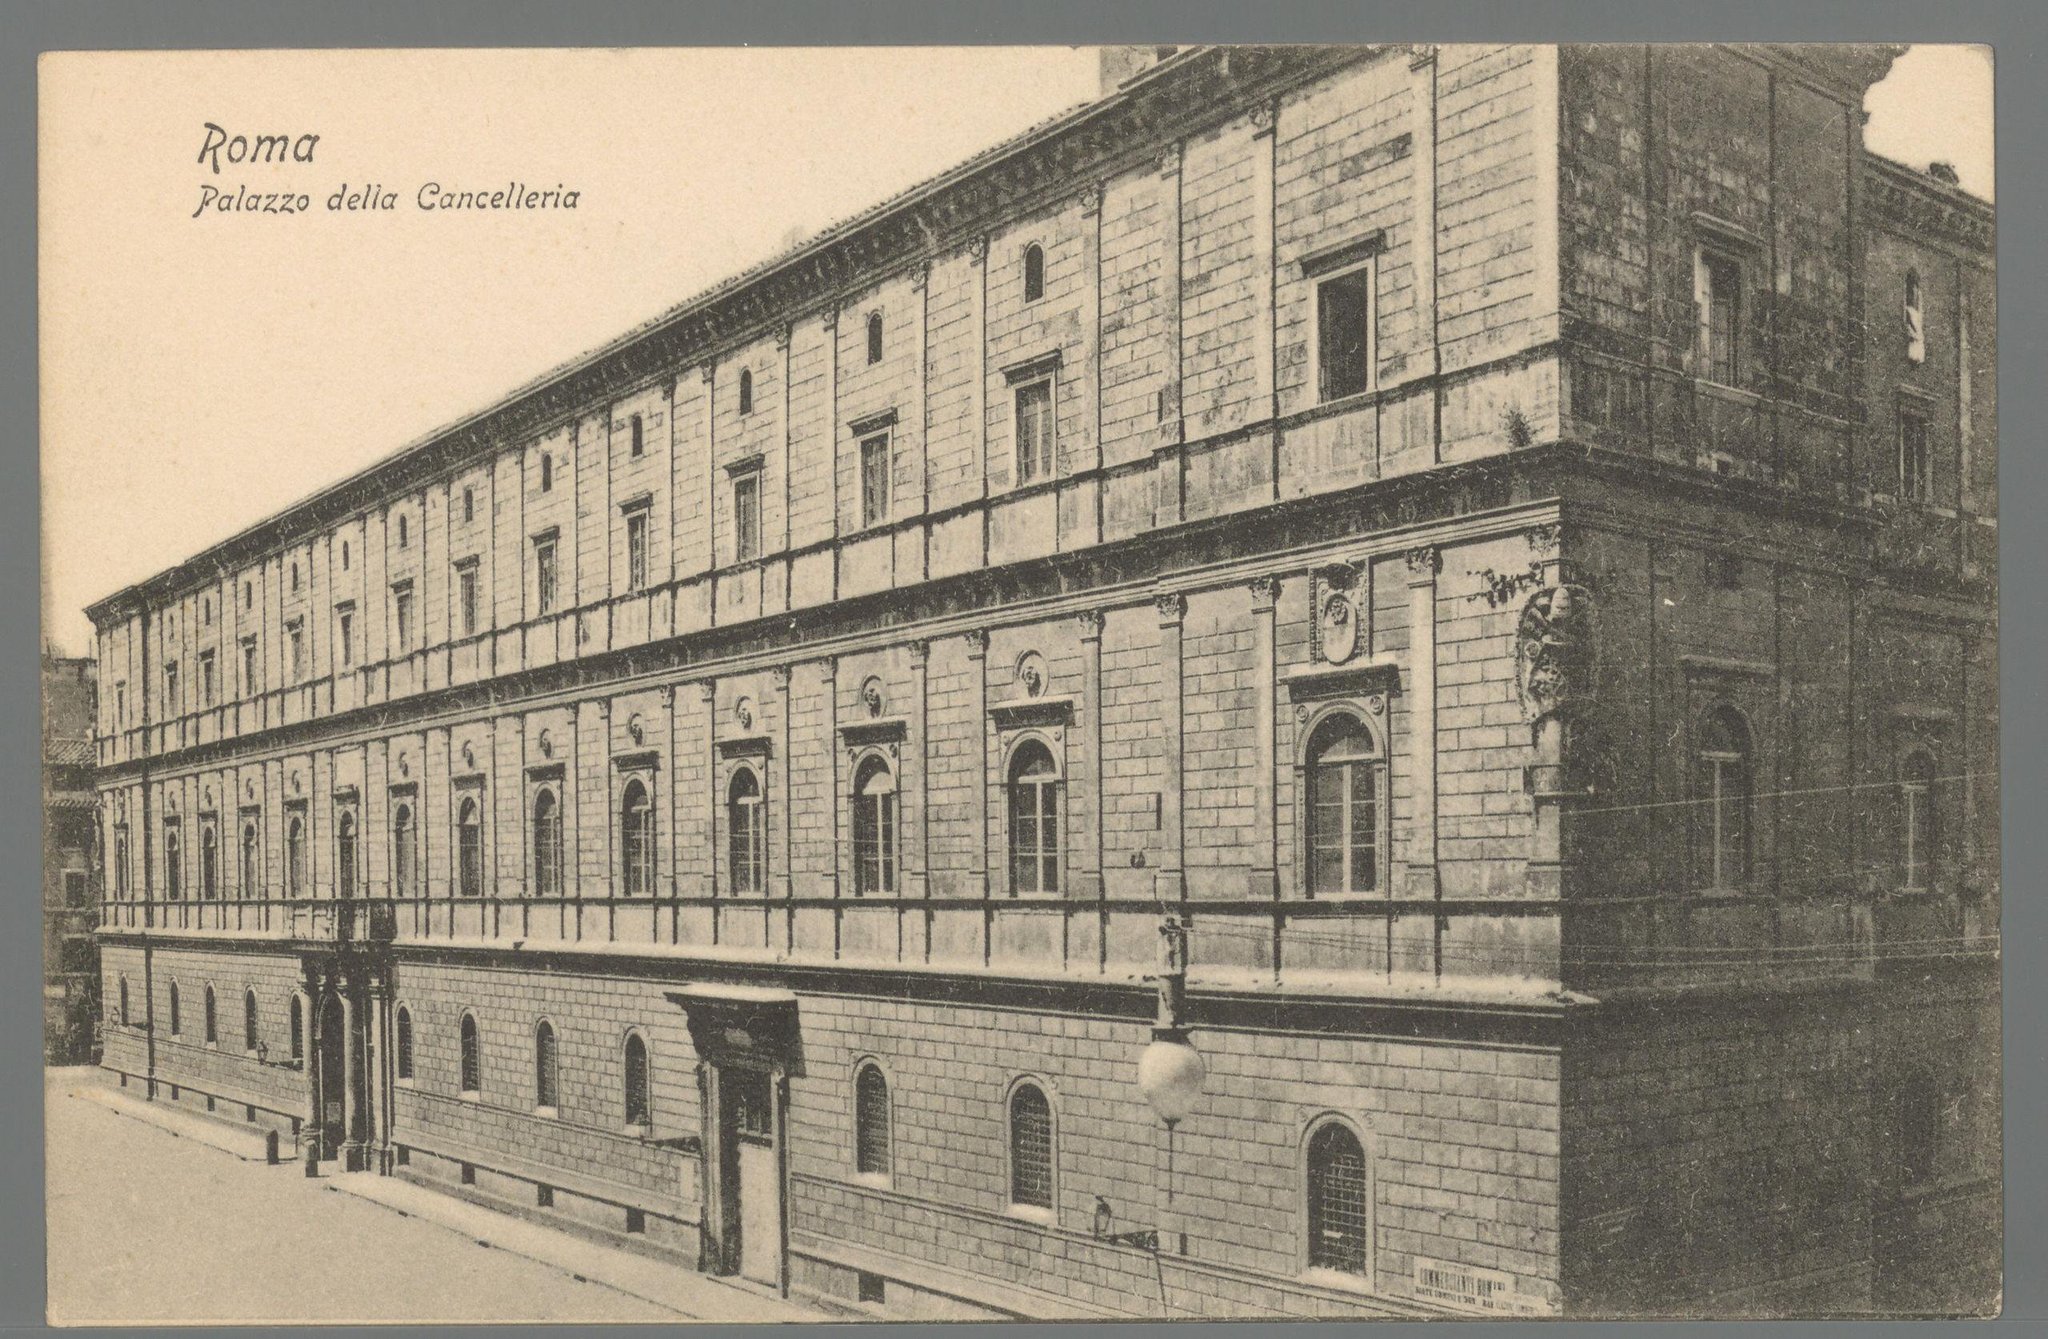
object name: ansichtkaart, prentbriefkaart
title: Roma. Palazzo della Cancelleria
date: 1889-1906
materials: cardboard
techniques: photograph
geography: florence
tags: palace